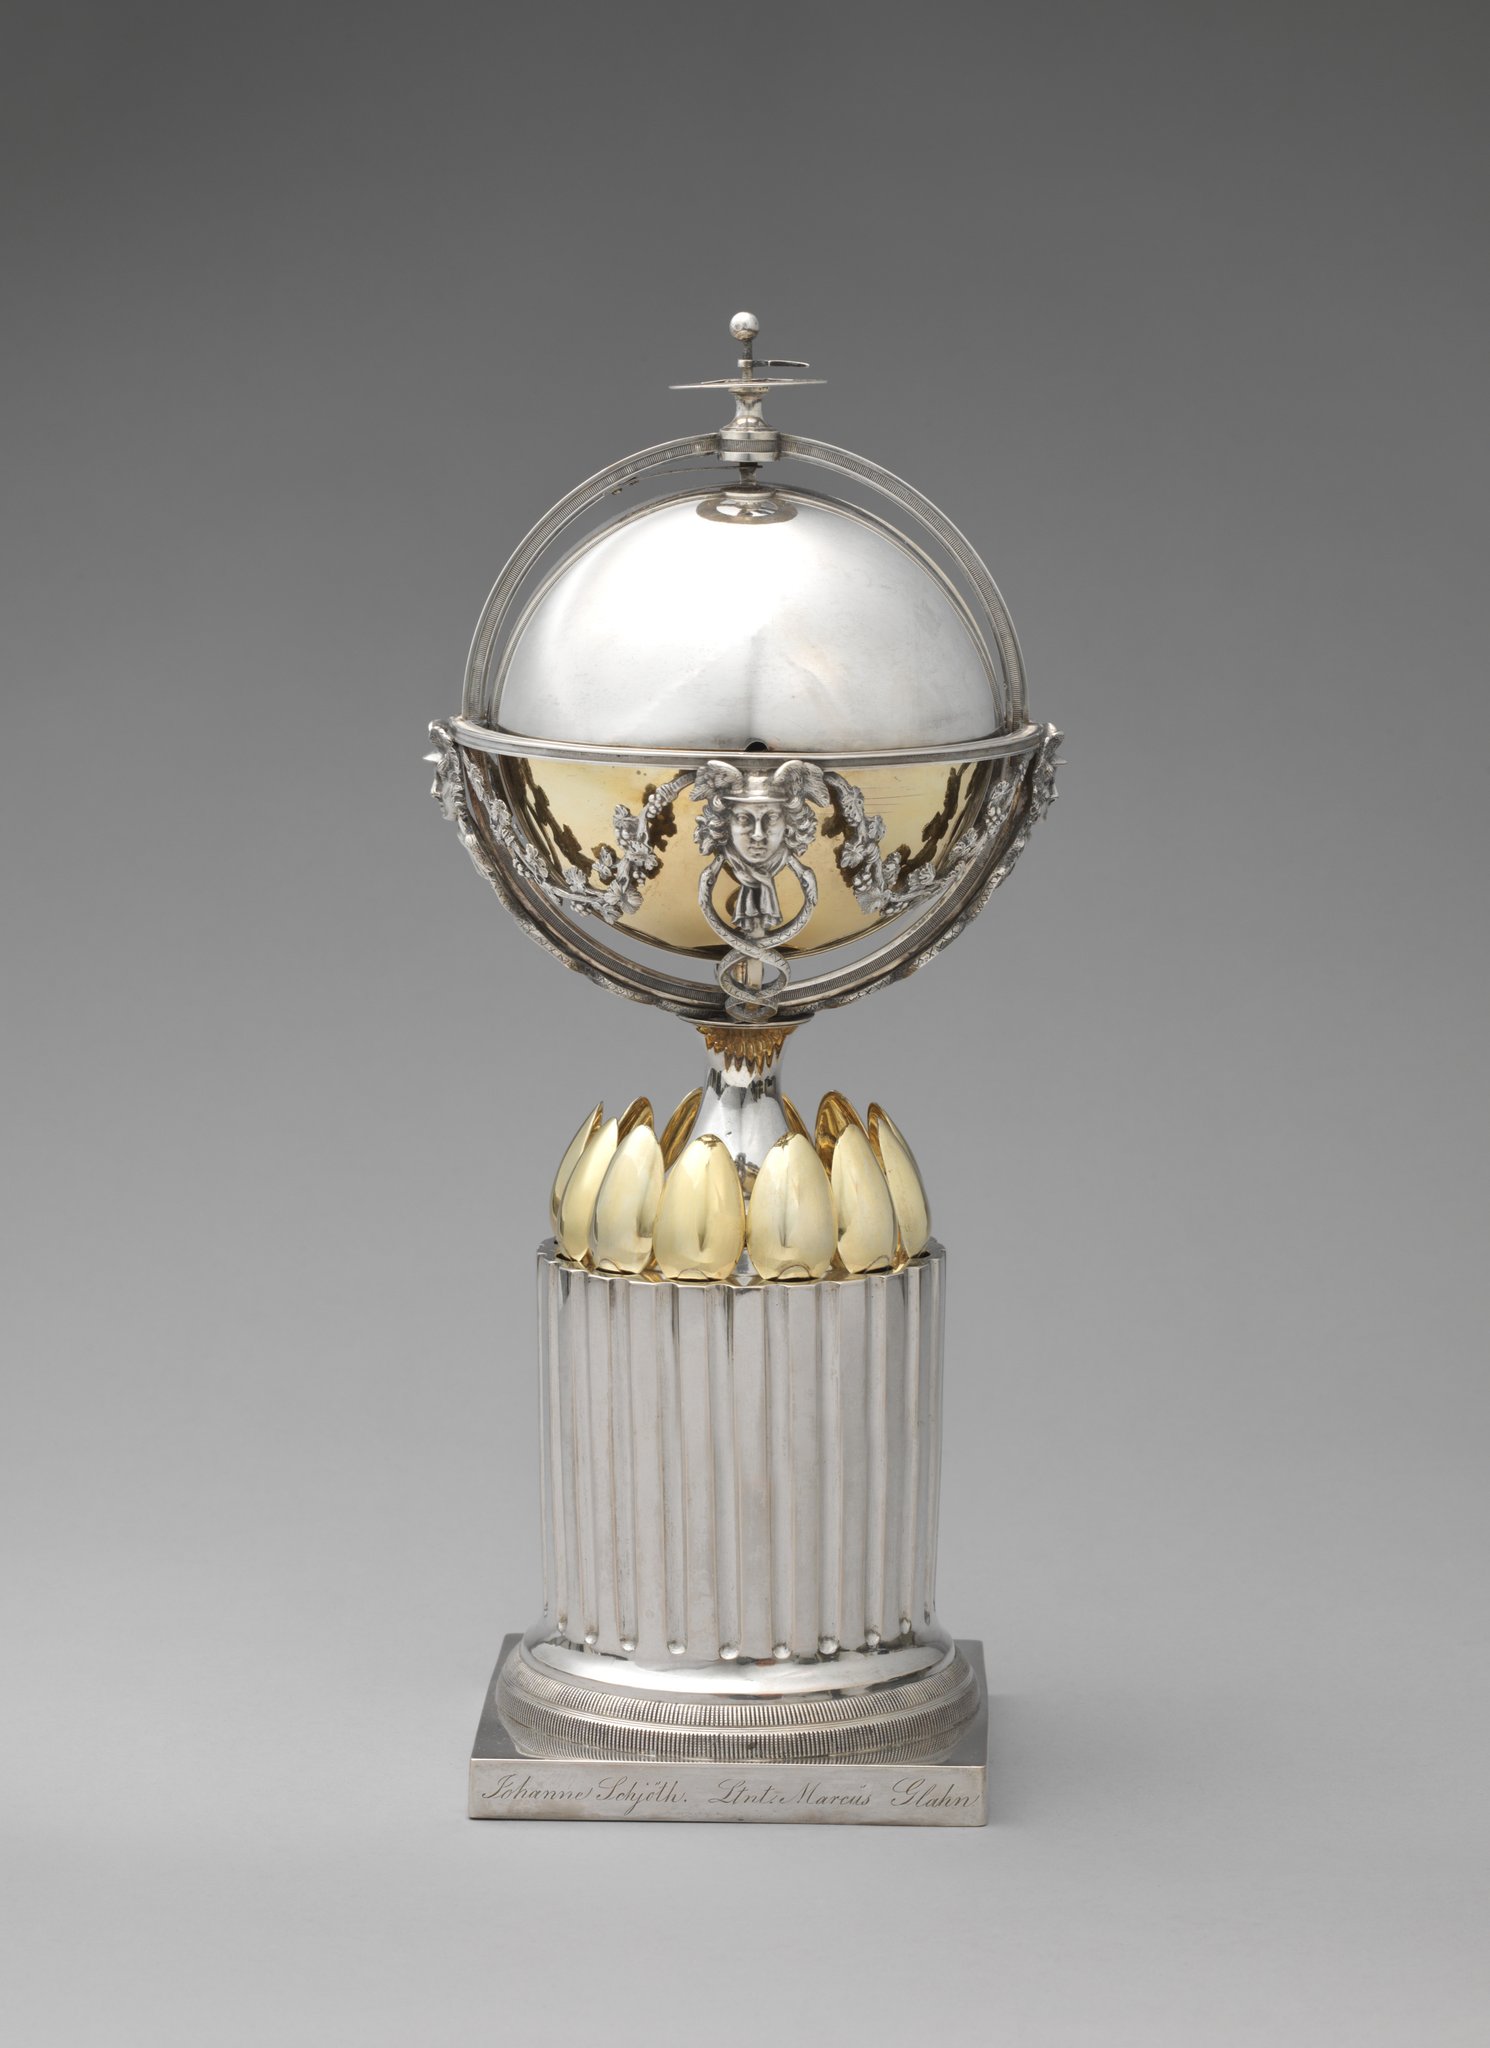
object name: sugar bowl and spoon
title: Sugar bowl and spoons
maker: bendix gijsen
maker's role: silversmith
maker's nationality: danish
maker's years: 1765-1822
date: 1804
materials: gilt, silver